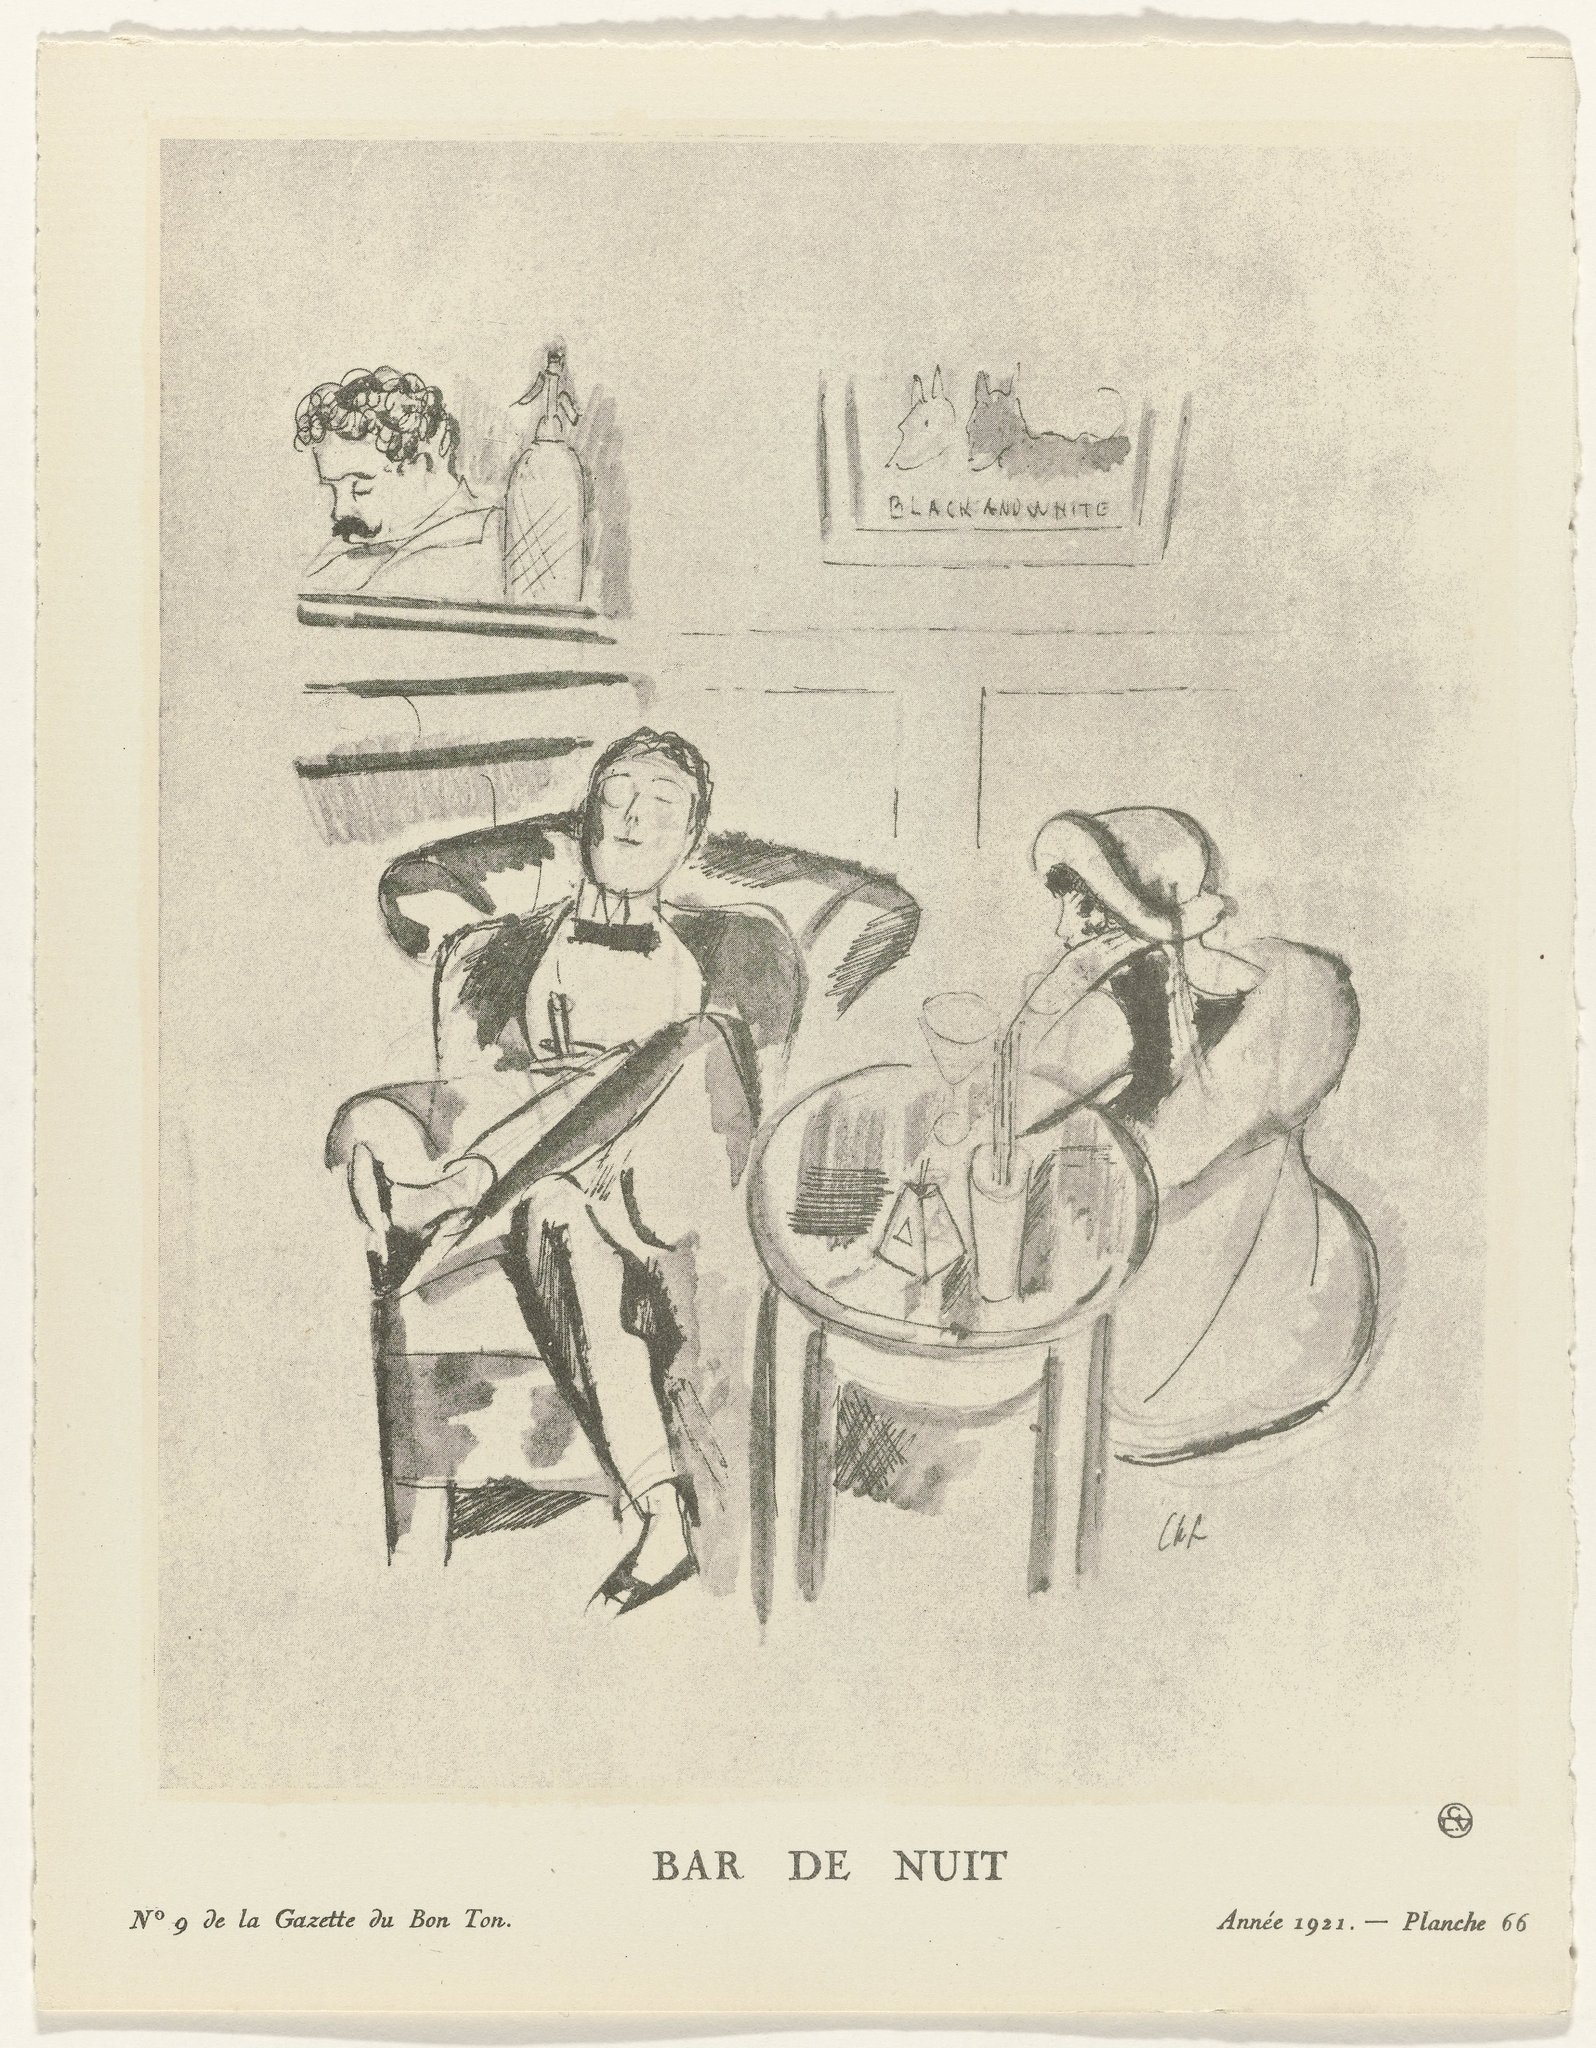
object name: fashion print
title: Gazette du Bon Ton, 1921 - No. 9, Pl. 66: Bar de nuit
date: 1921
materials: paper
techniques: letterpress printing, photochemical processes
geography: london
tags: ensembles of pieces of clothing (suit) (+ men's clothes), head-gear (+ women's clothes), inn, coffee-house, public house, etc., fashion plates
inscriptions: date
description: Man. zittend met de benen over elkaar, in een smoking. Sigaar in de hand. Naast hem zit een vrouw, op de rug gezien, met op het hoofd een cloche (pothoed). Achter de bar een slapende man. Planche 66 uit Gazette du Bon Ton 1921, No. 9. Uitleg over de prent op pagina "Explication des Planches Hors-Texte. Contenues dans le numéro 9."